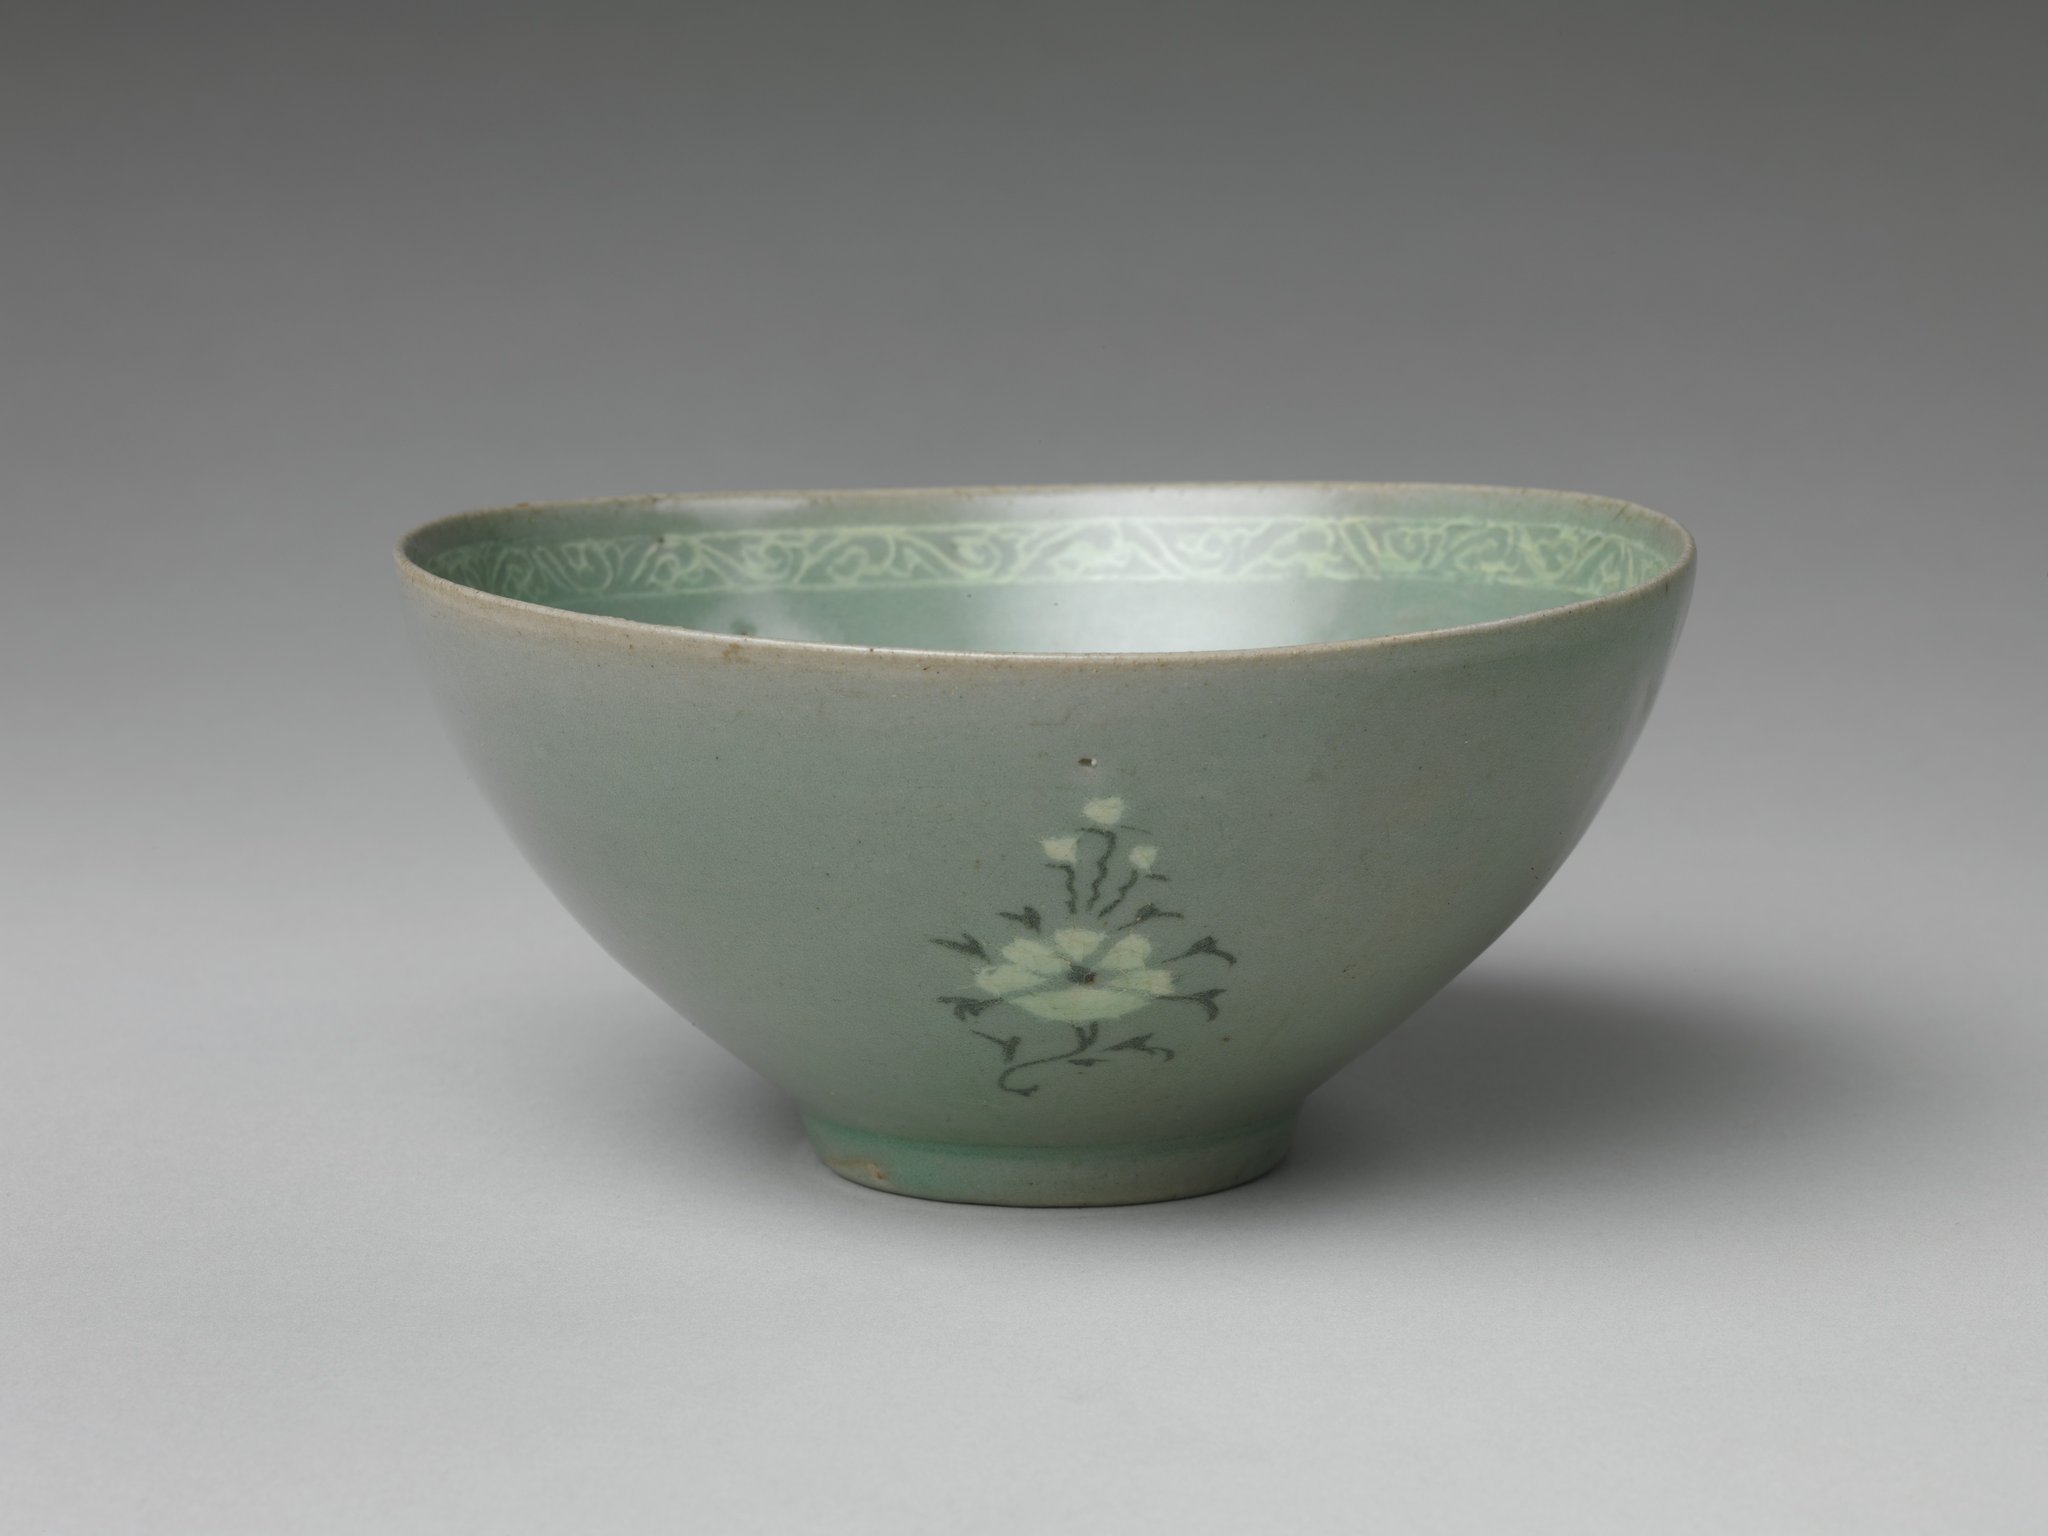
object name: bowl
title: Bowl with decoration of fish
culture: korean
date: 1151-1200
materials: ceramic glaze, glaze, stoneware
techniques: inlay